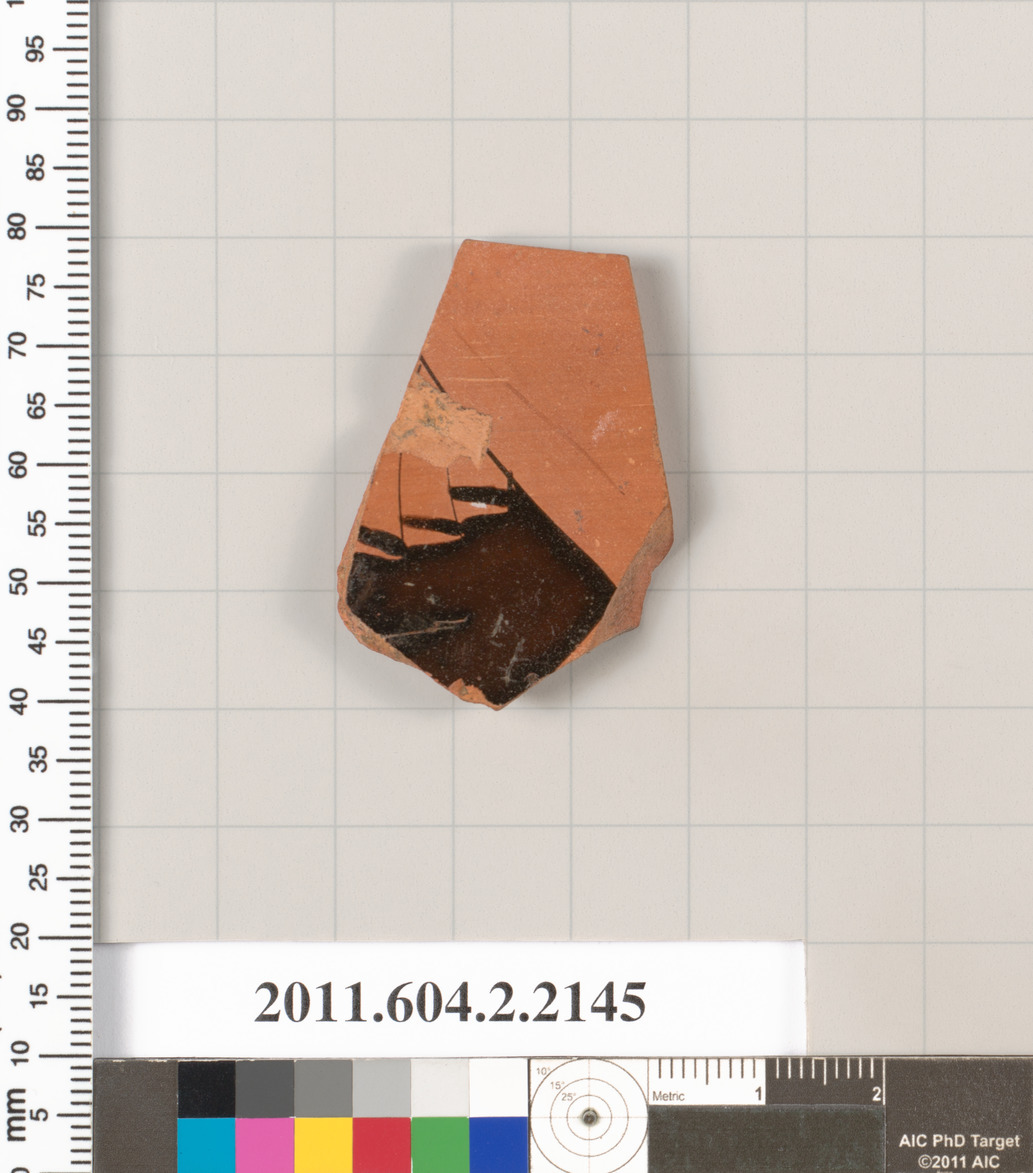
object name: pot fragment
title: Terracotta fragment of a pot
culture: greek, attic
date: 475-451 BCE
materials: terracotta